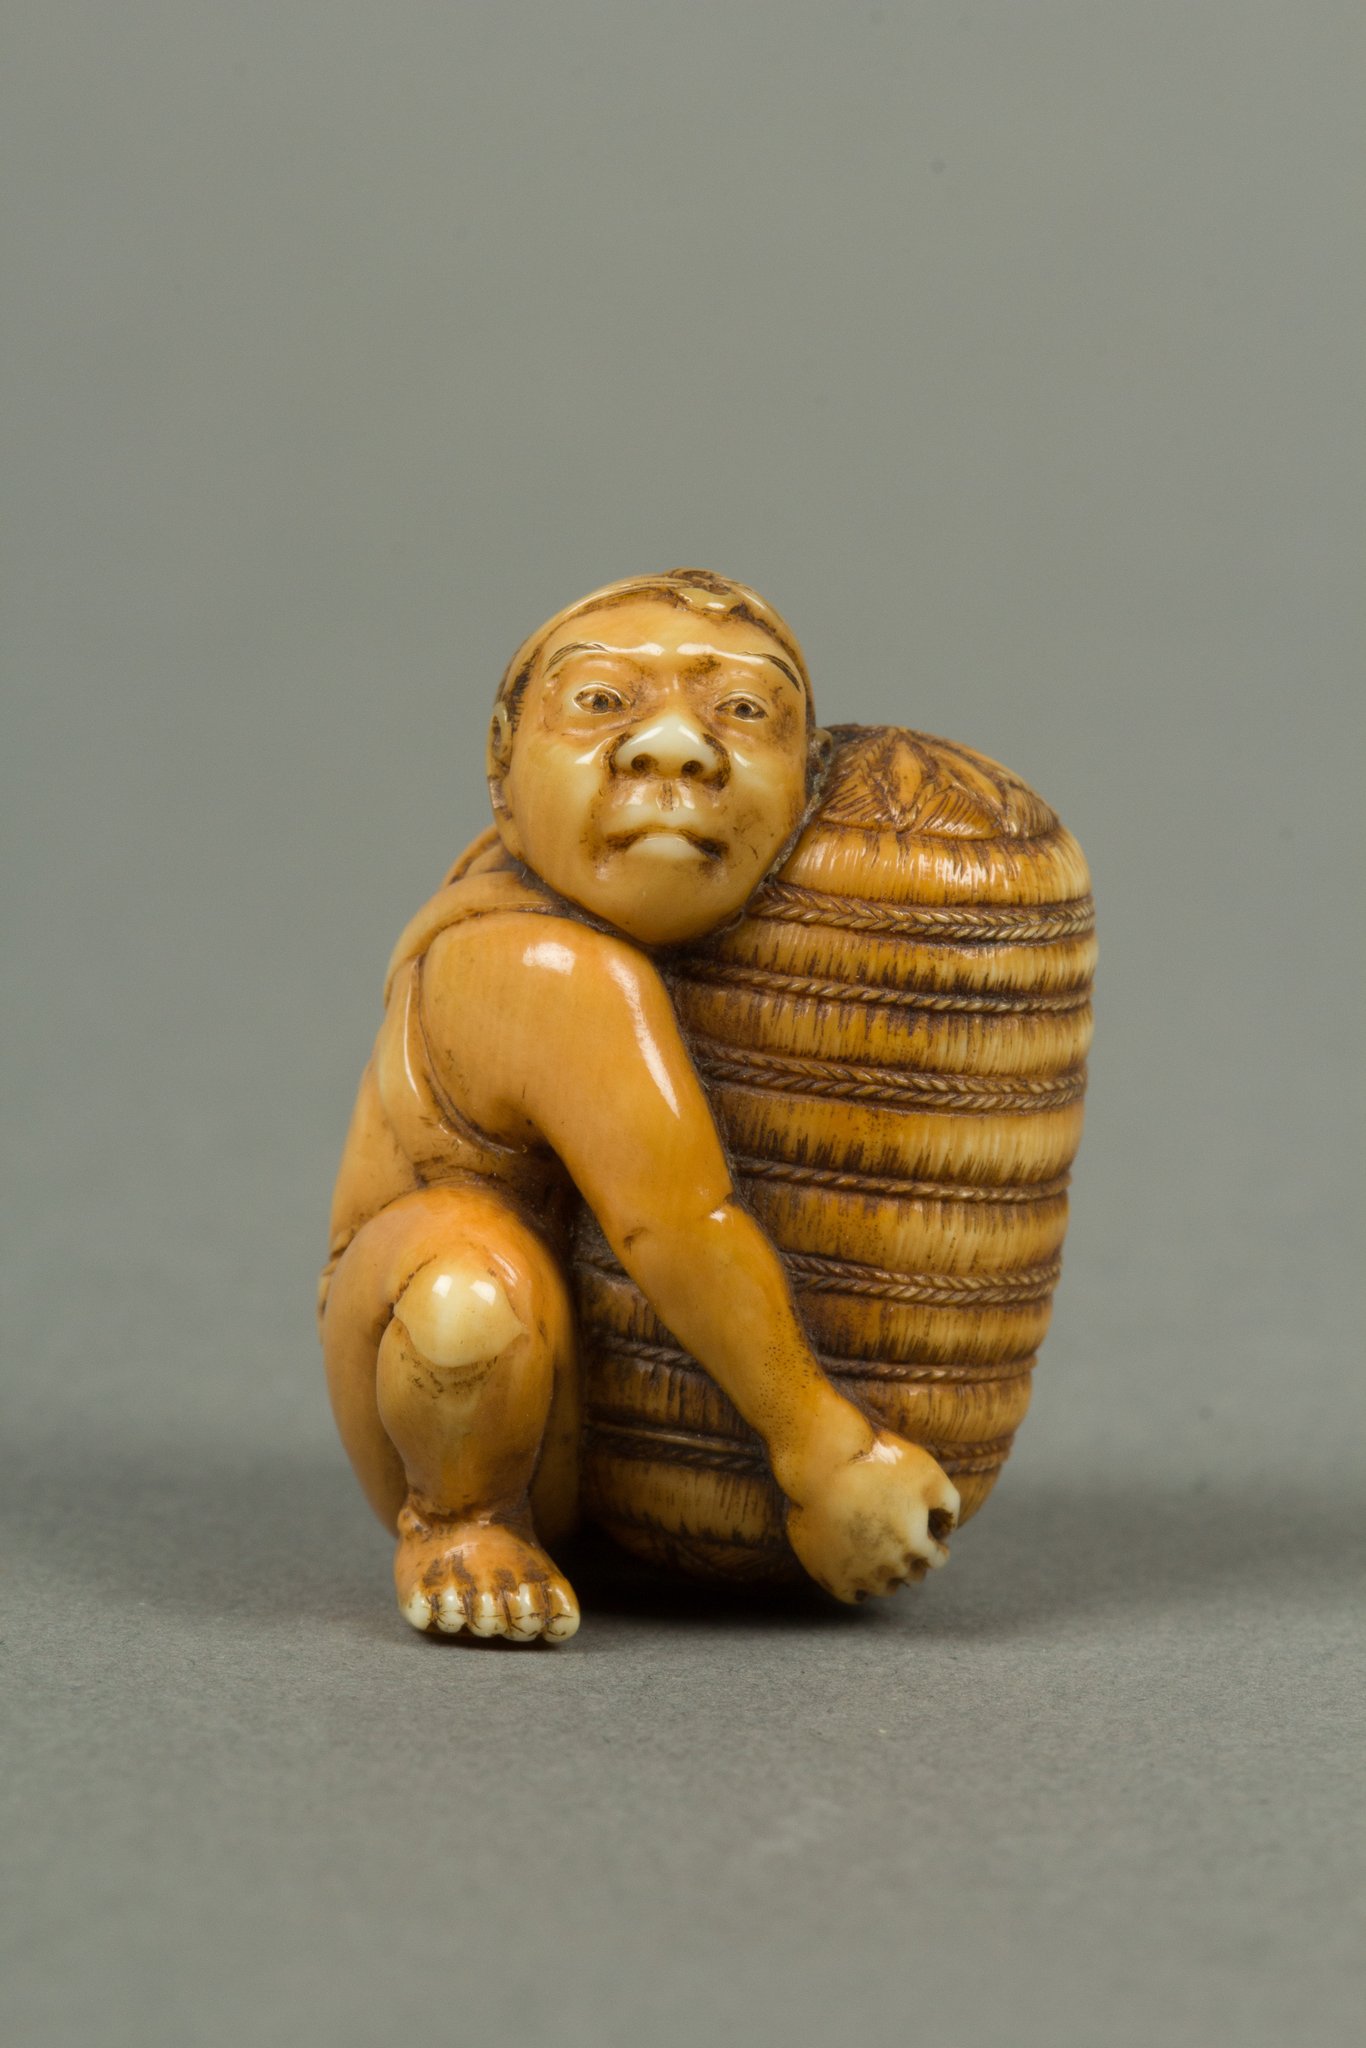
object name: netsuke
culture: japanese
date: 1801-1900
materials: ivory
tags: men